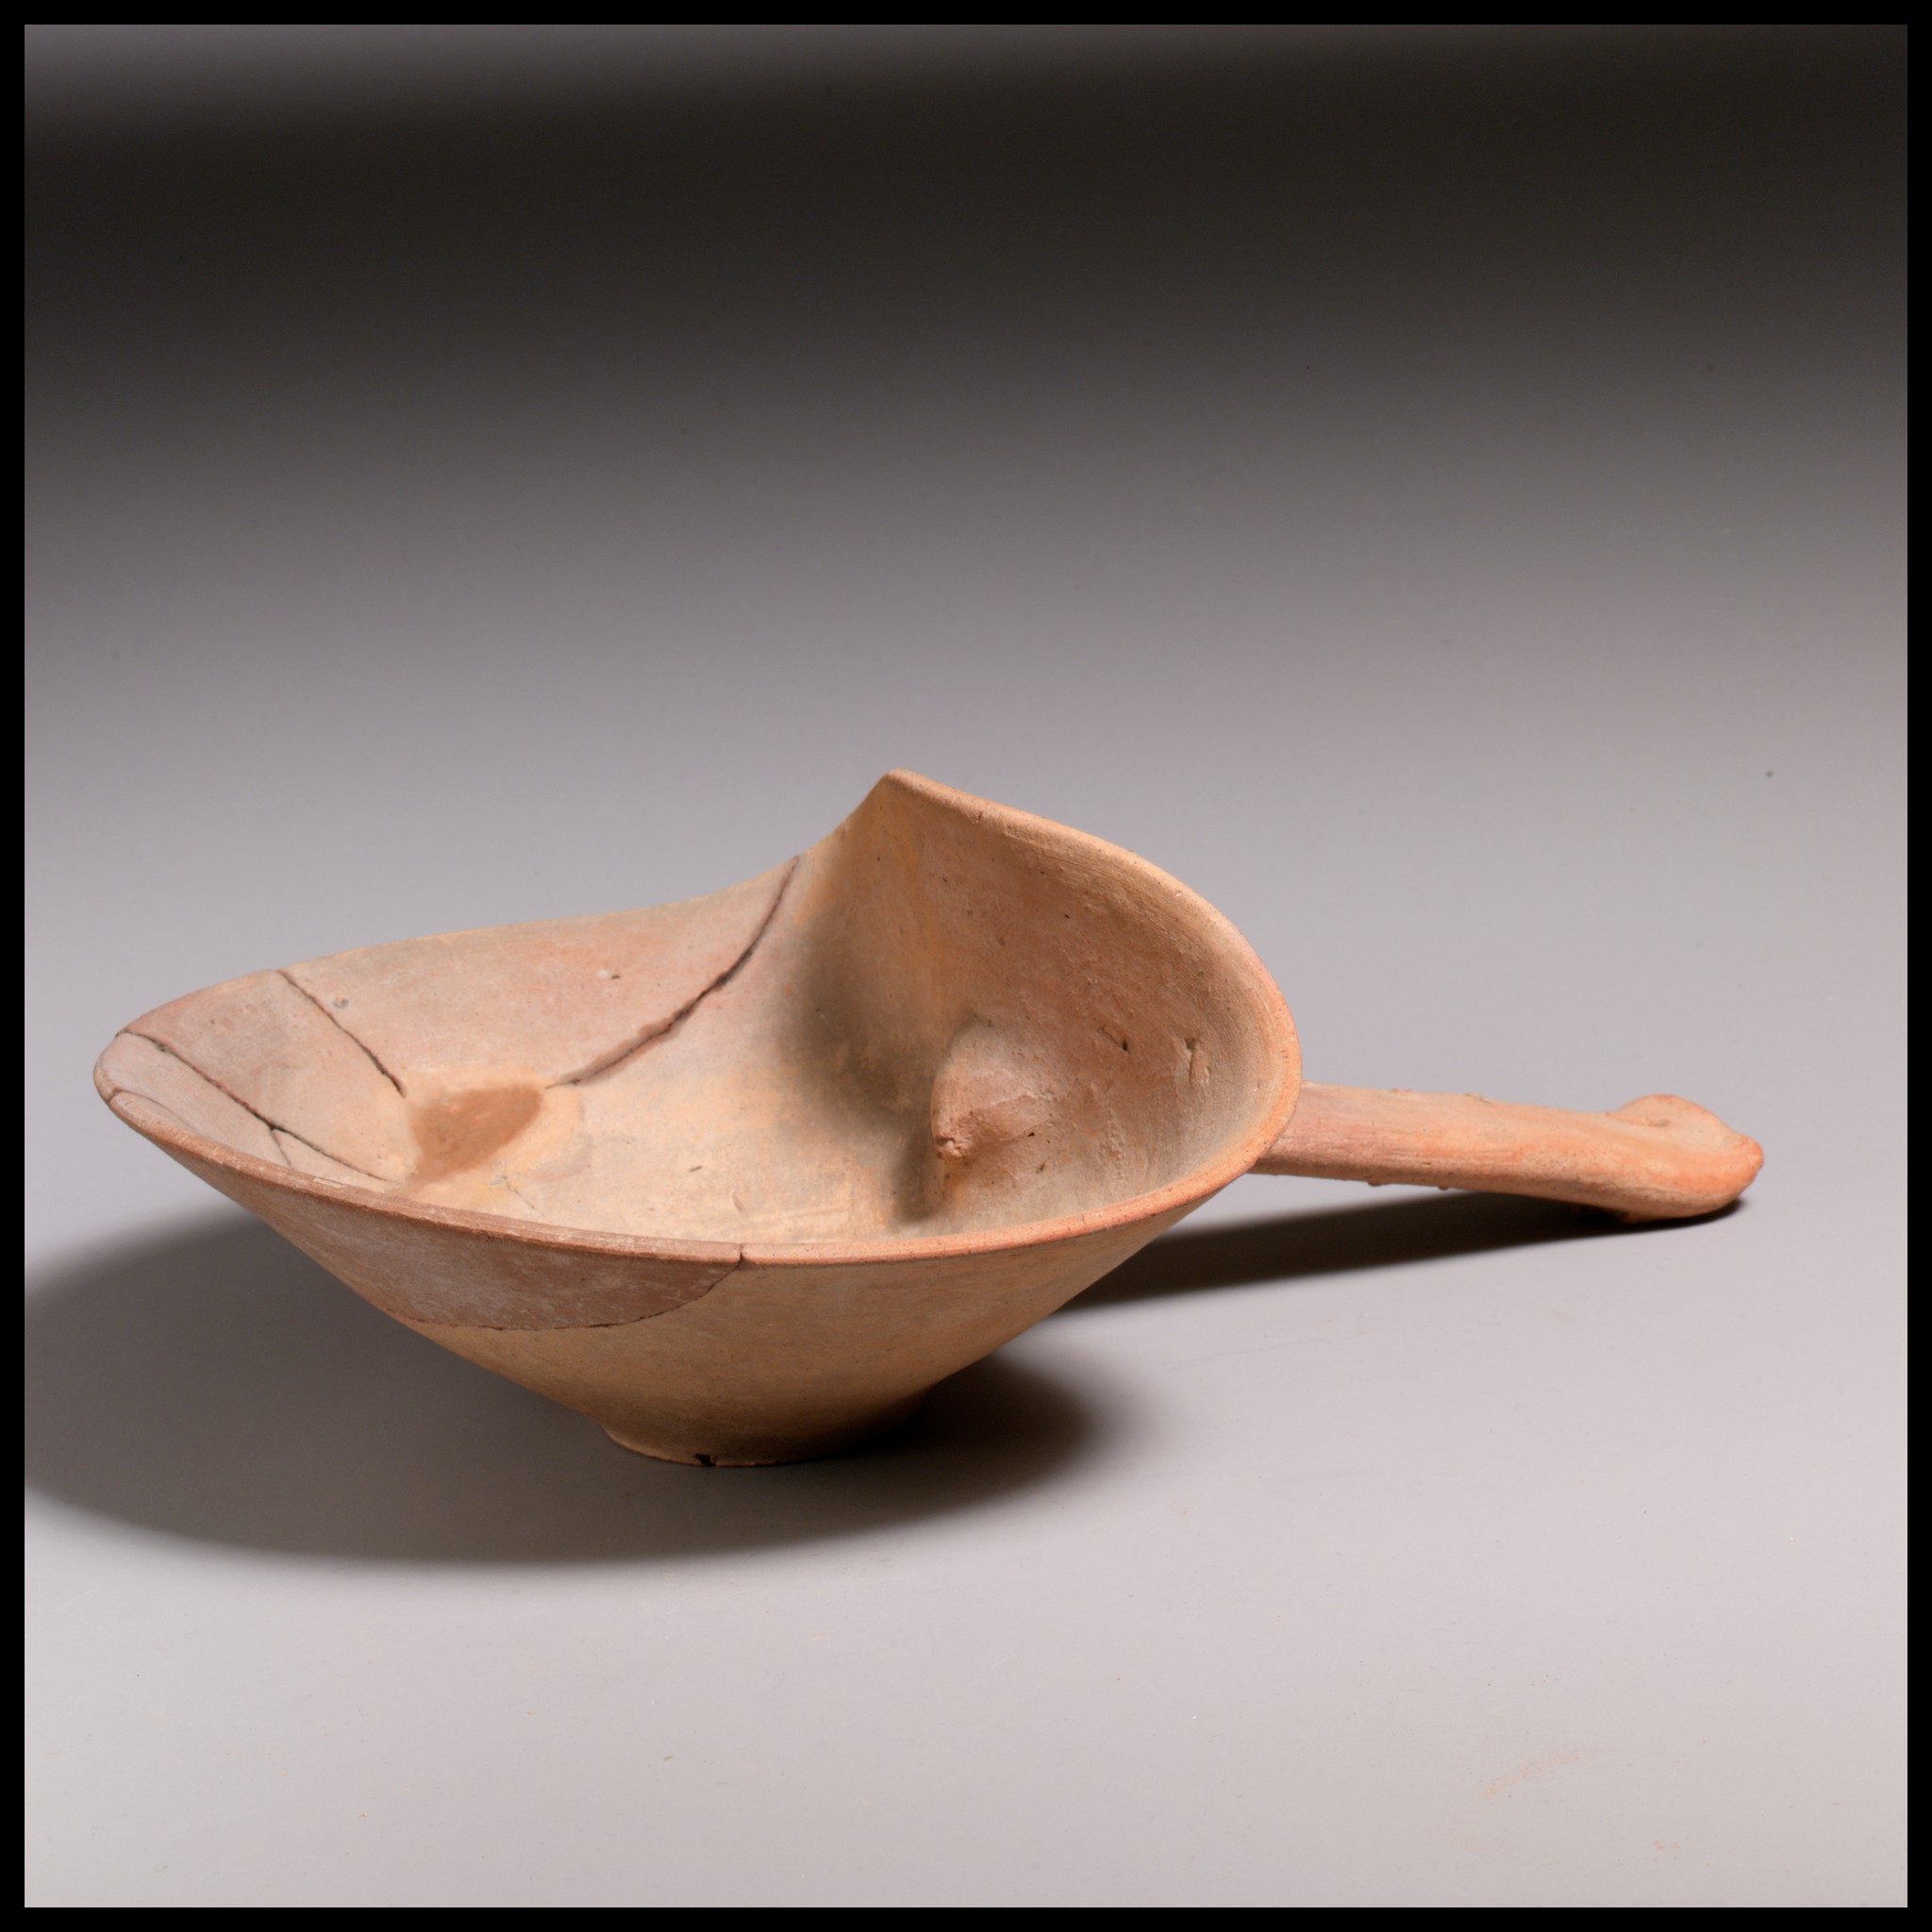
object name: ladle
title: Terracotta scuttle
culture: mycenaean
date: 1400-1190 BCE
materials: terracotta